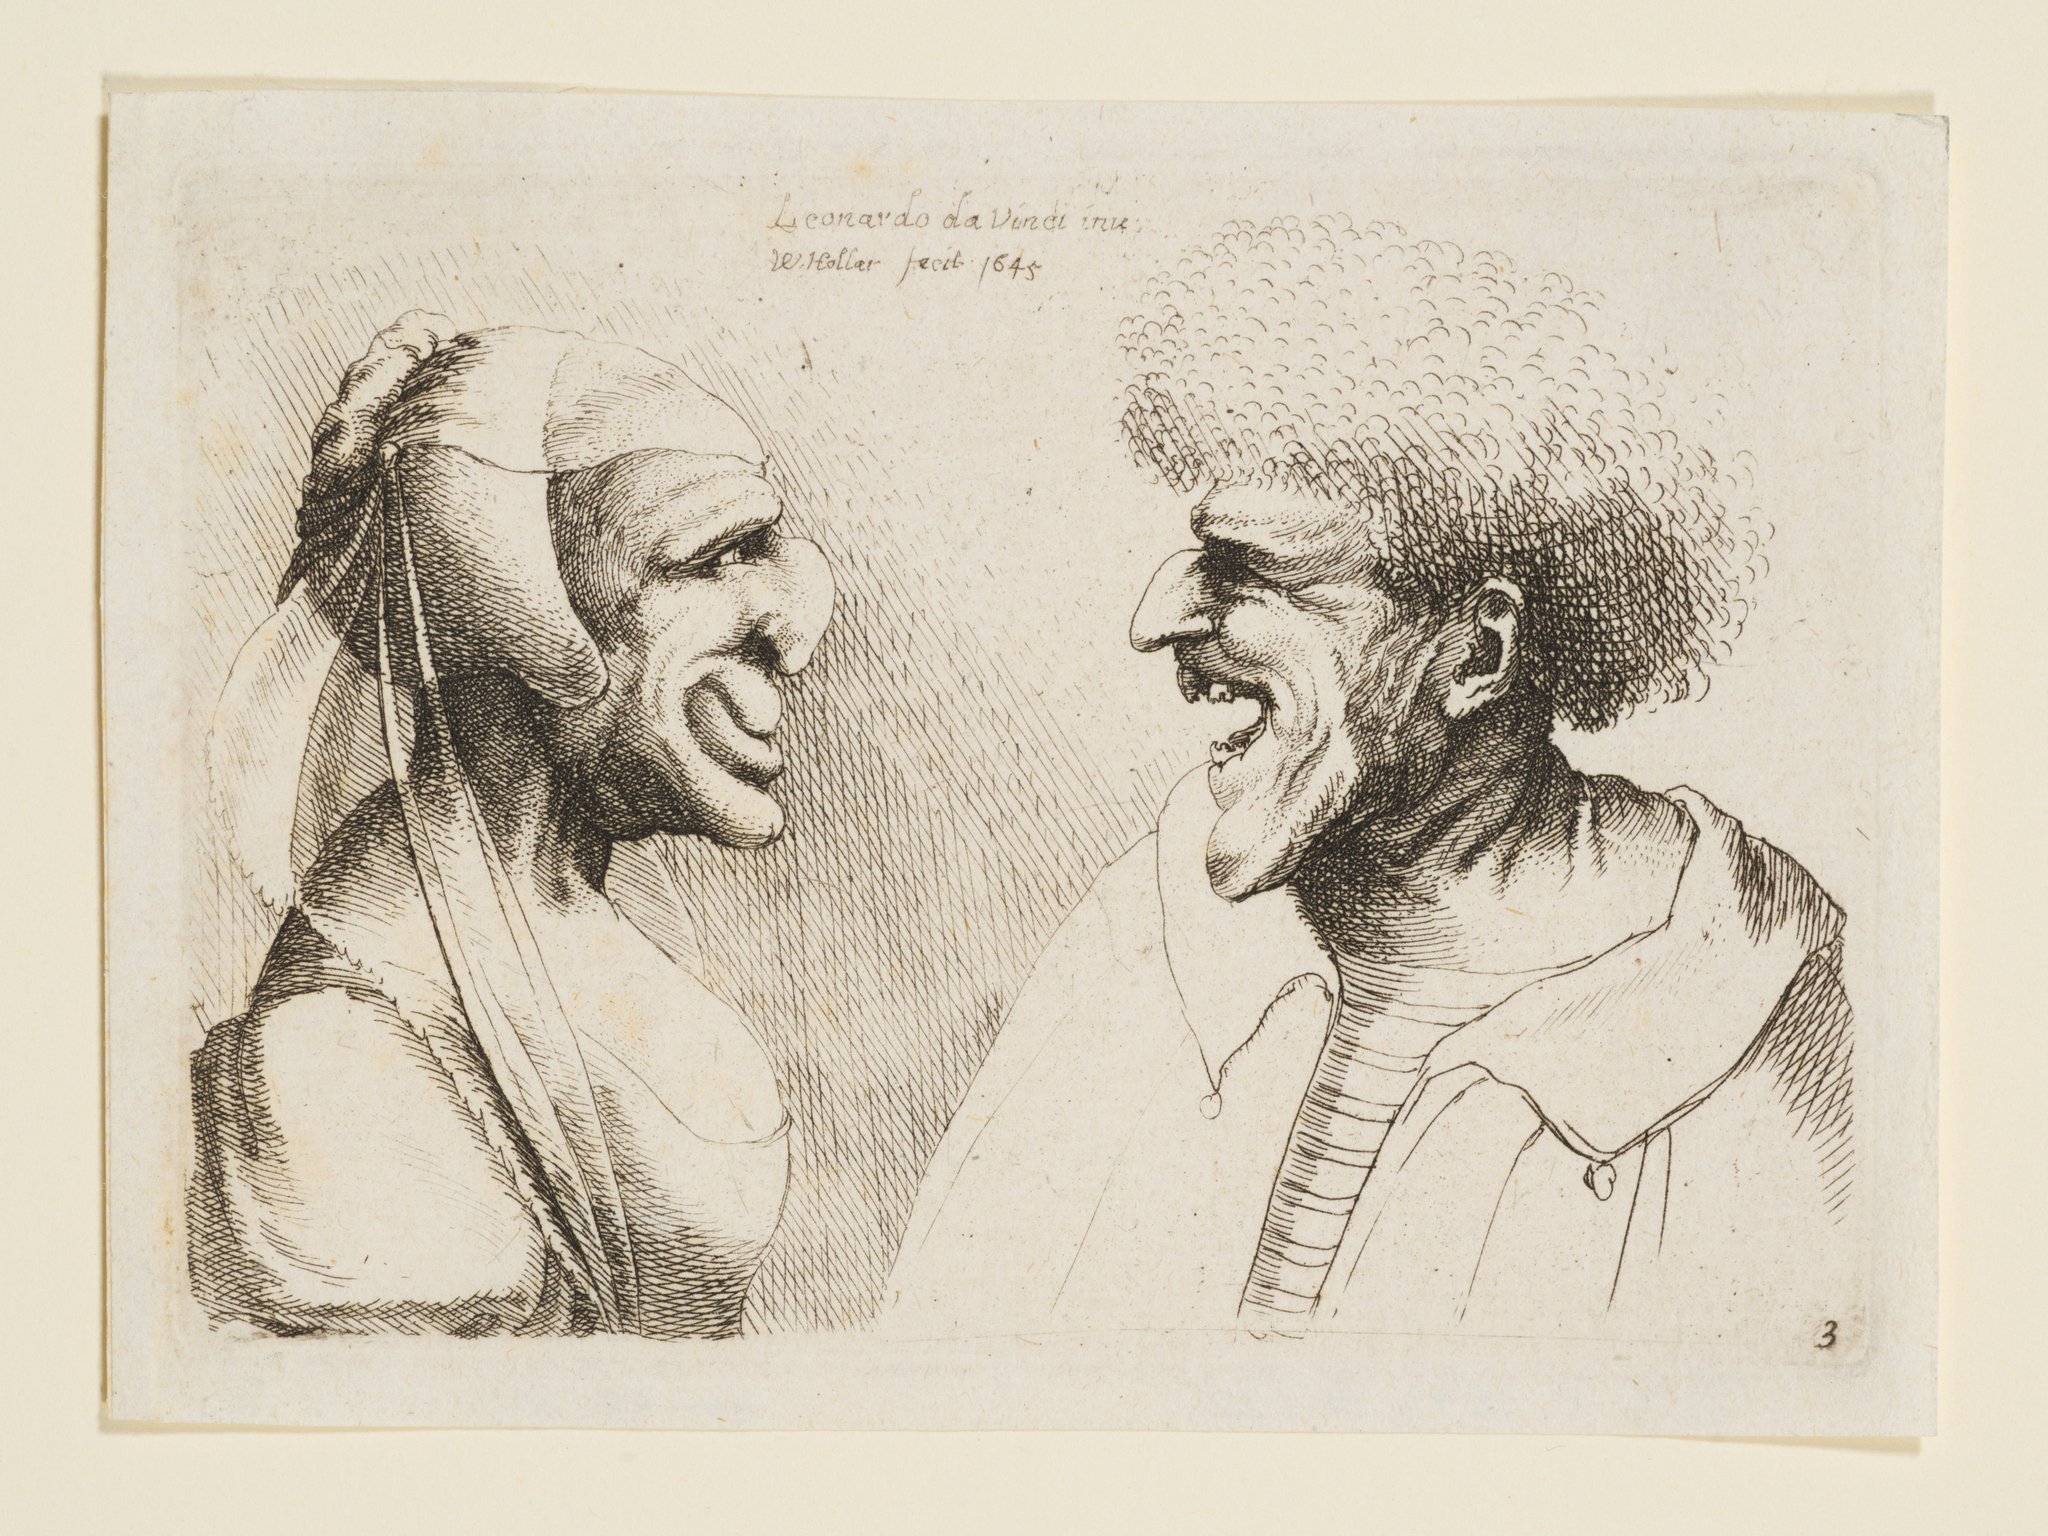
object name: print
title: Two Deformed Heads Facing Inwards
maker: wenceslaus hollar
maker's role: artist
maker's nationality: bohemian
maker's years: 1607-1677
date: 1645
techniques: etching